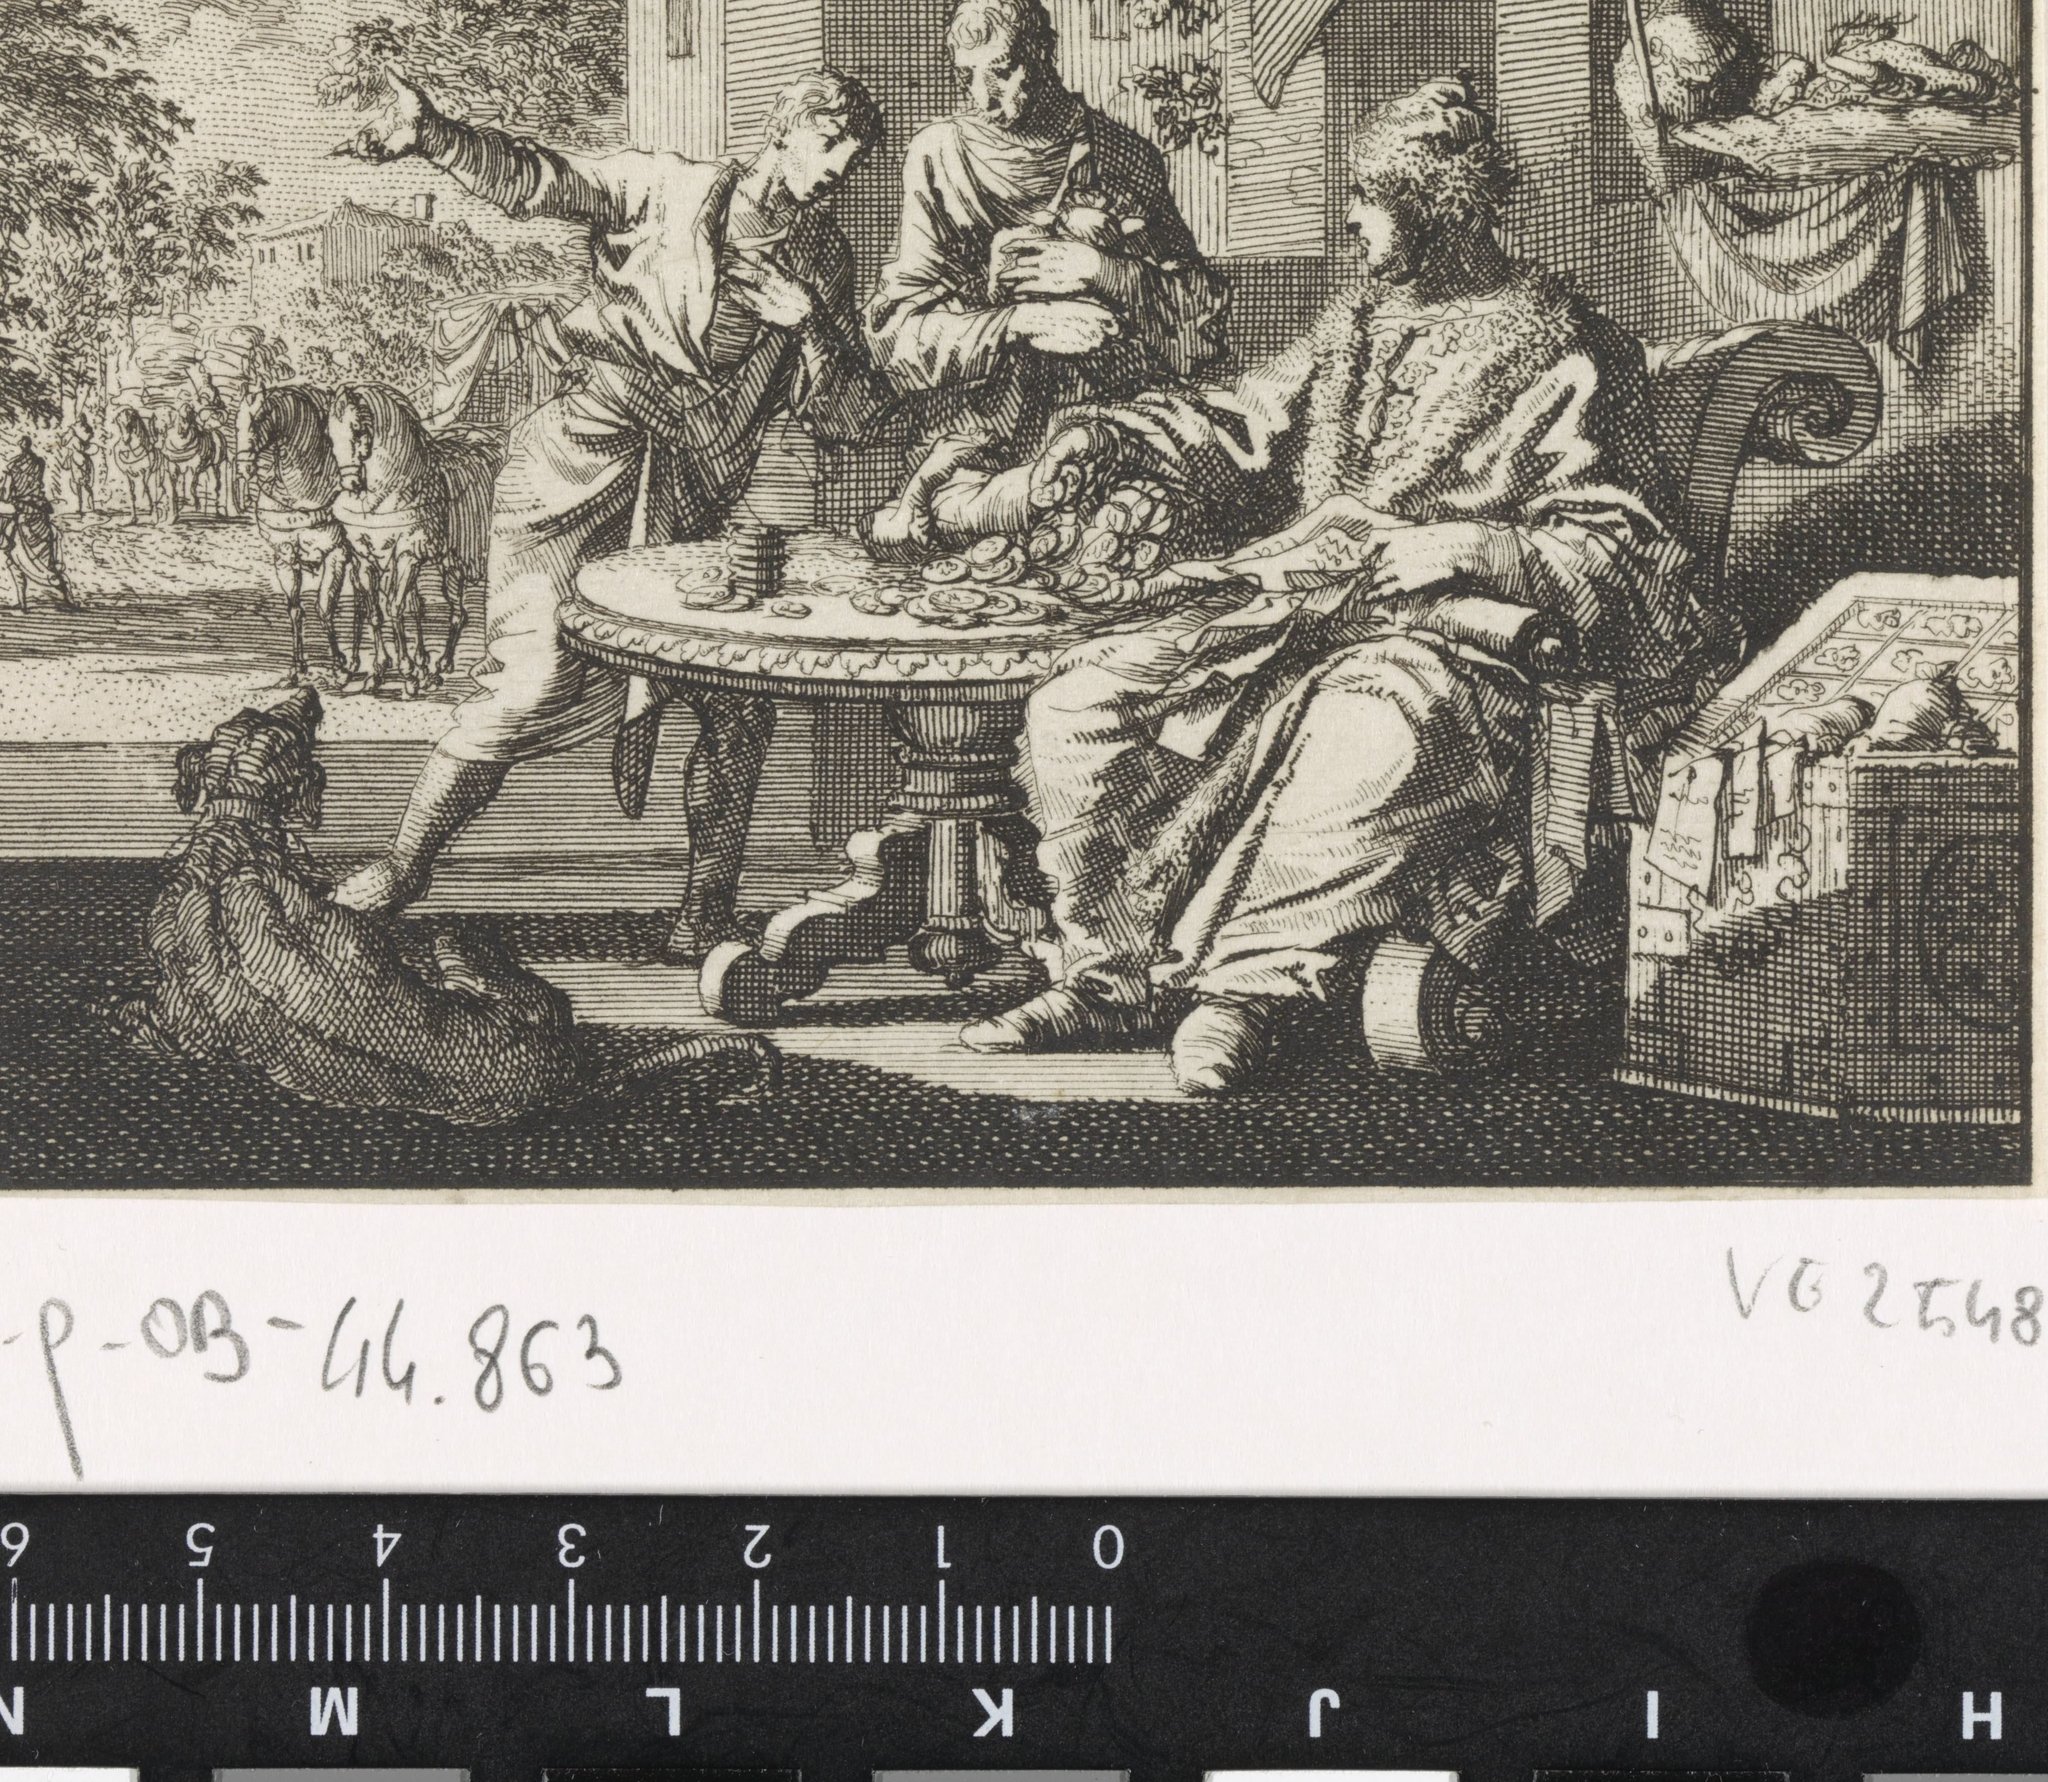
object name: print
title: Embleem: rijkdom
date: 1695-1705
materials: paper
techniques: etching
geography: nuremberg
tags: the rich, interior of the house, exhibition of wealth, display of jewels, etc., abstract ideas and concepts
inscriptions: collector's mark: Lugt 240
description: Boekillustratie voor Weigel, Christoph. Ethica Naturalis seu Documenta Moralia e Variis rerum Naturalium proprietatibus Virtutum Vitiorumq symbolicis imaginibus collecta. Neurenberg: Christoph Weigel: c. 1700.